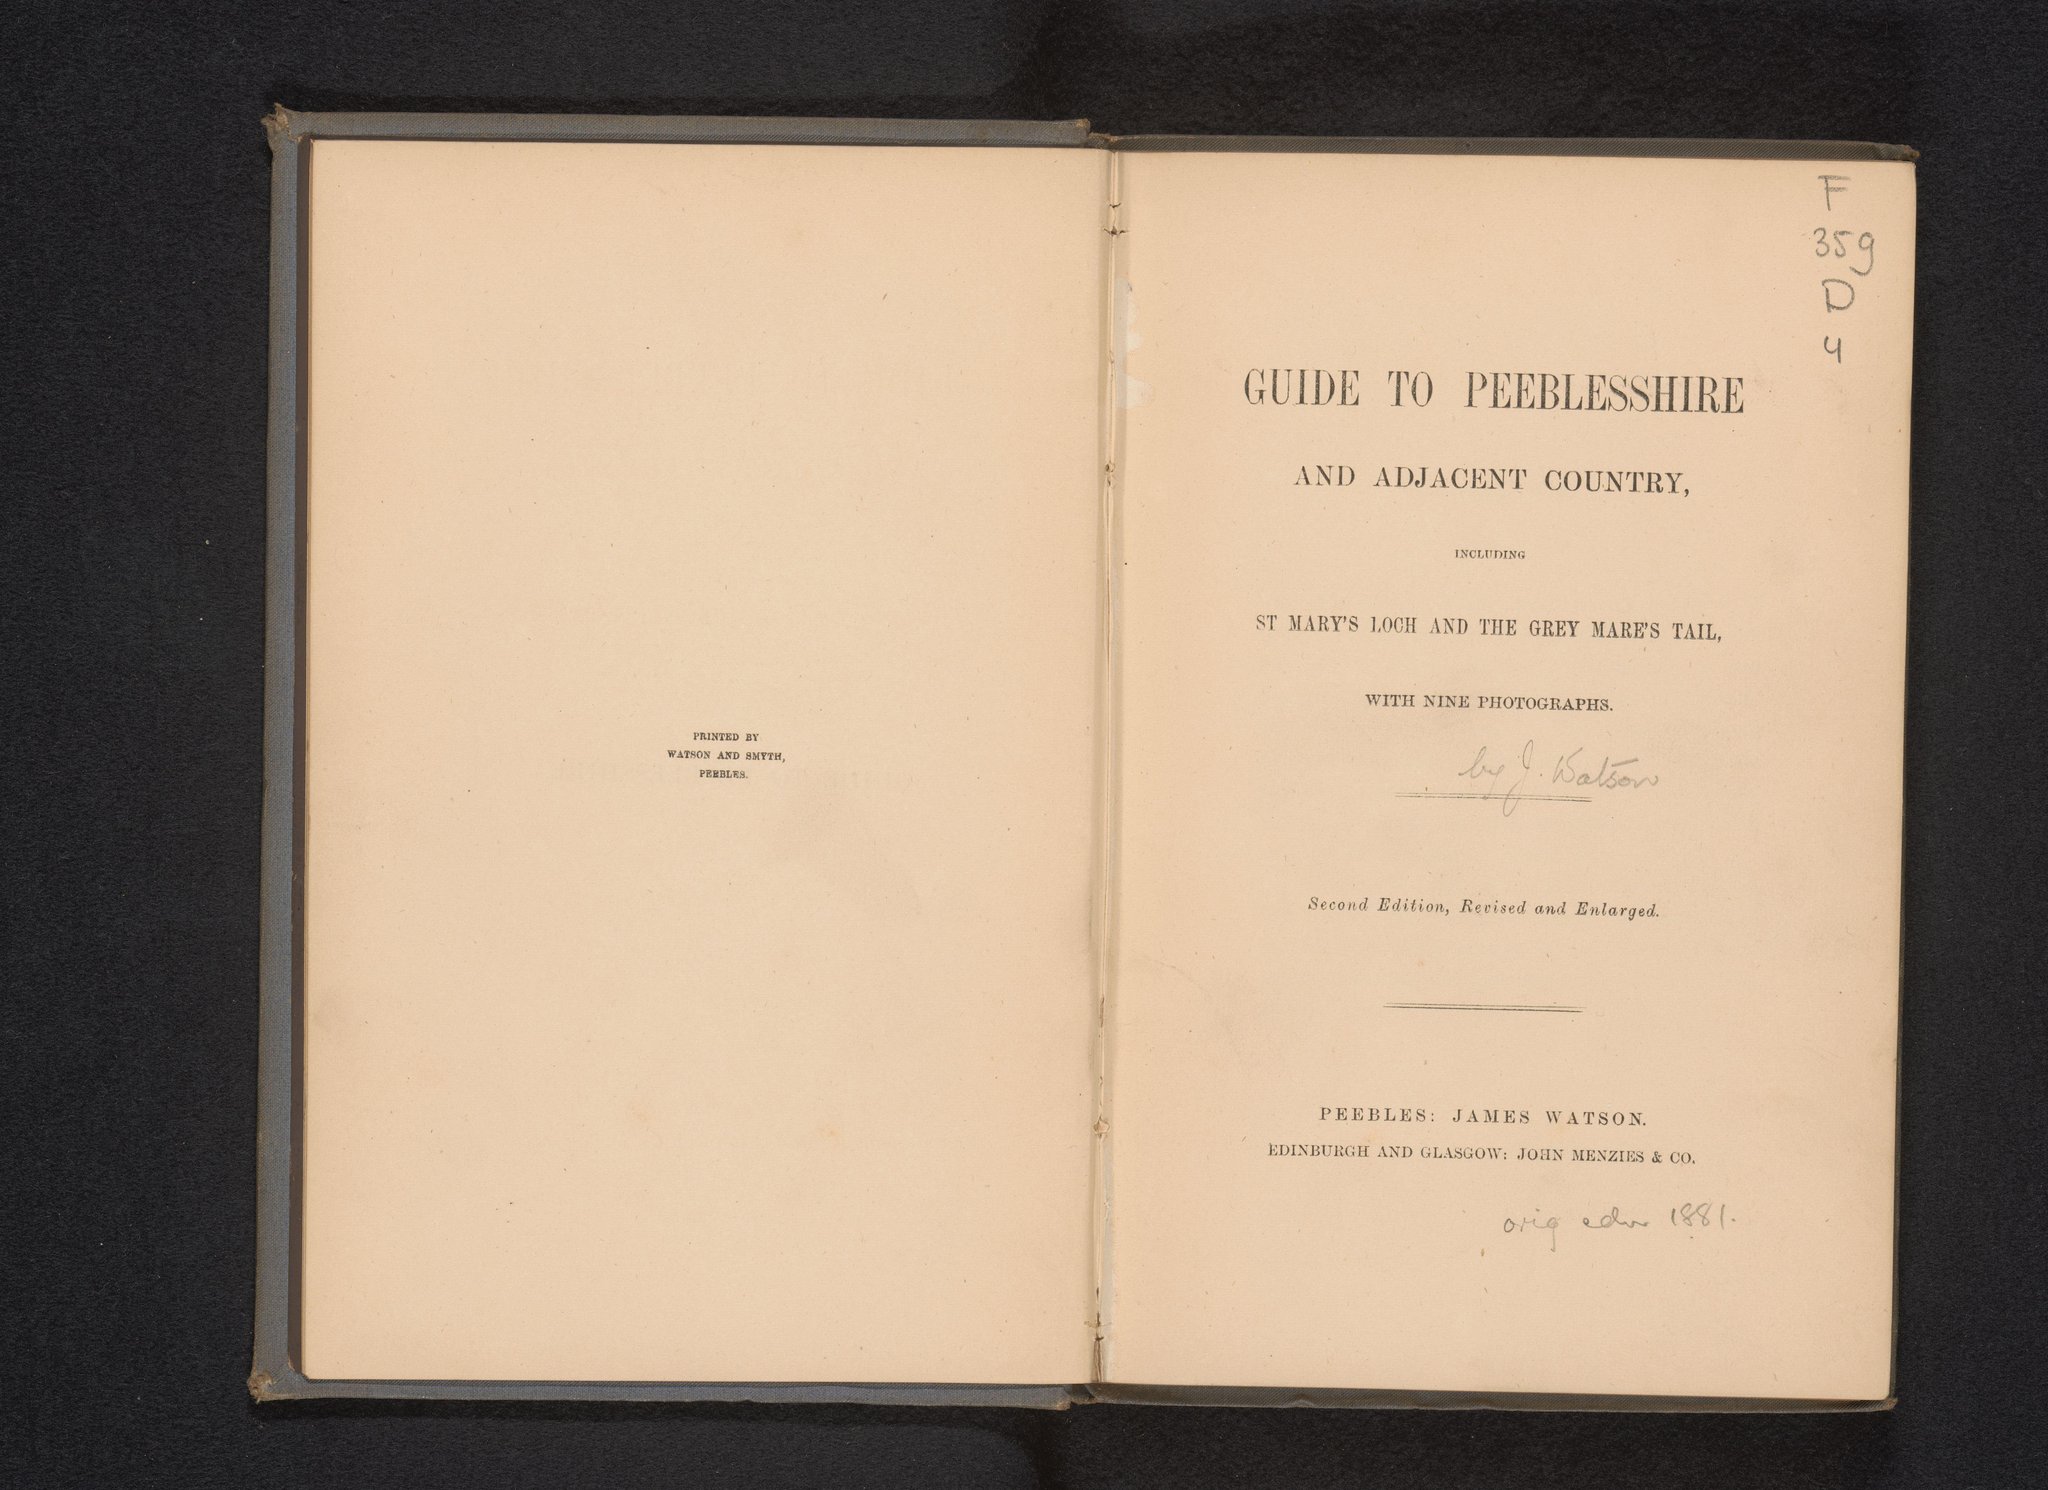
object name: book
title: Guide to Peeblesshire and adjacent county, including St. Mary's Loch and the Grey Mare's Tail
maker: james watson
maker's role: printer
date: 1881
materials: linen, paper, photographic support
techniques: albumen print, printing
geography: peebles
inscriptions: bookplate: ‘ex libris SFJ’, annotation: ‘Apr 1981’, annotation: ‘[...] 301-’